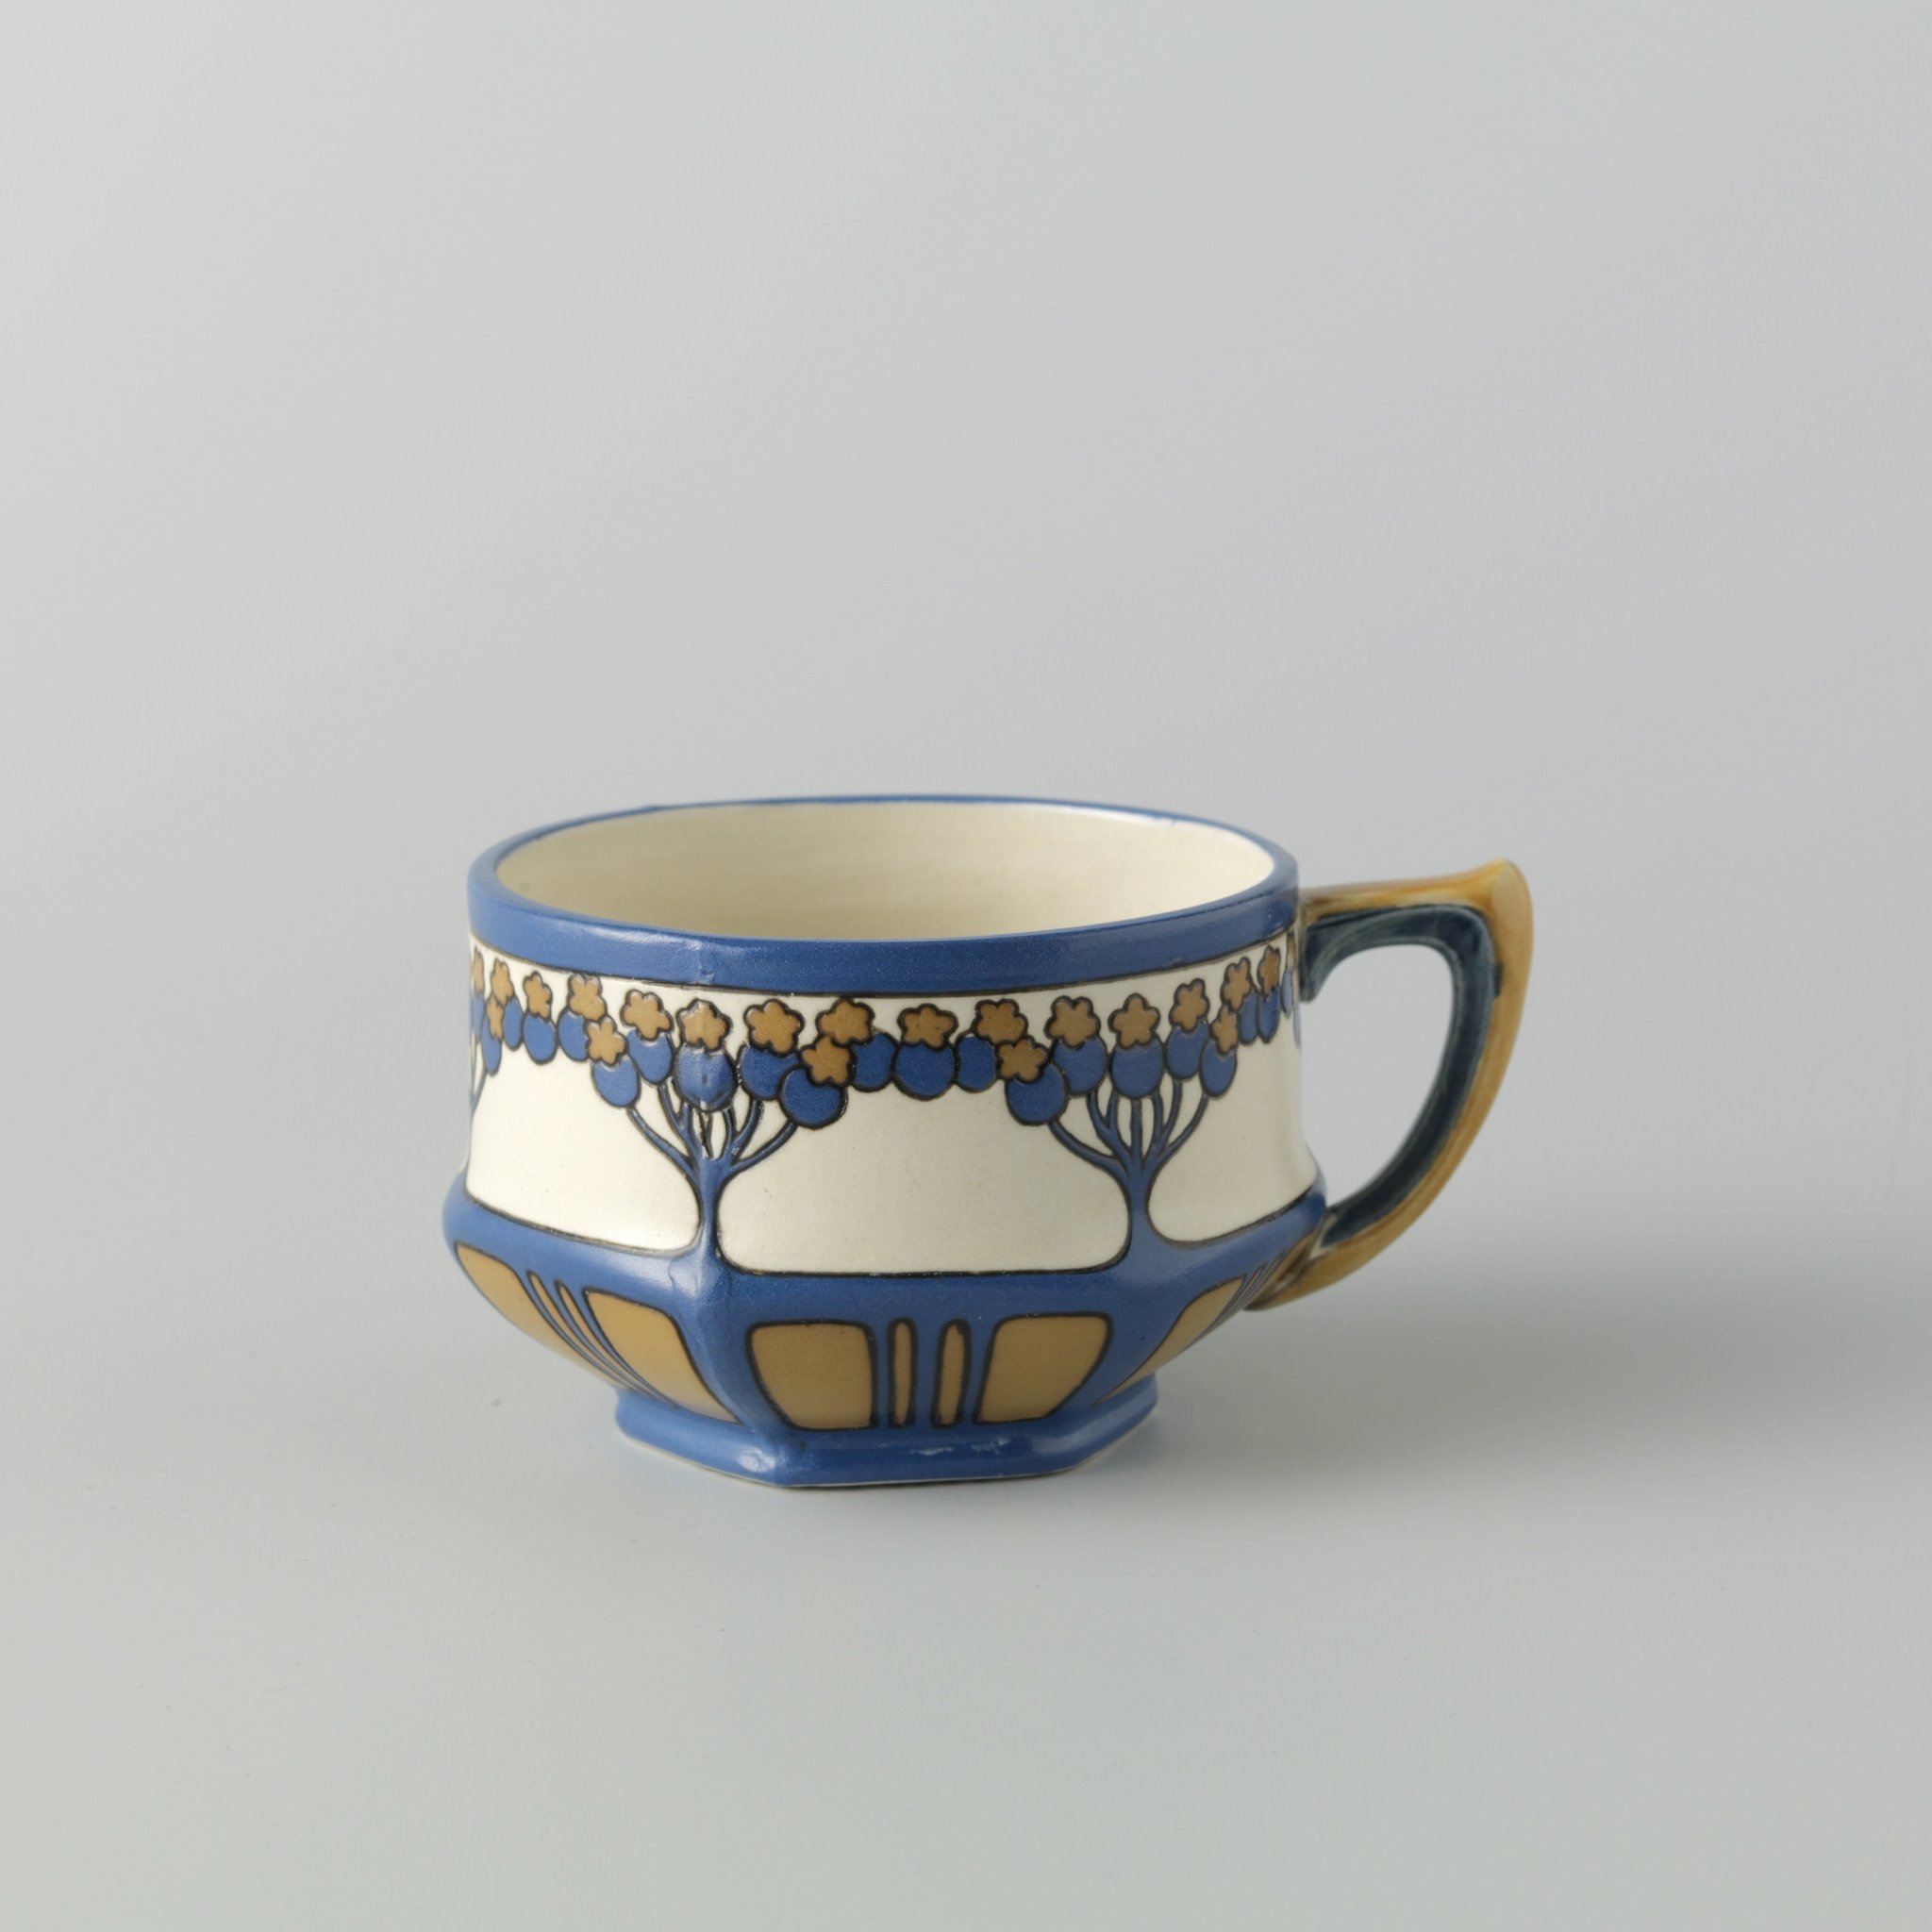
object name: cup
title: Kop, behorende bij een theeservies van chromolith steengoed, versierd in blauw en geelbruin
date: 1911-1912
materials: stoneware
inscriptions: mark: ‘ingedrukt toren // METTLACH waaronder VB in naamplaat, Ges.Gesch., Reg. U.S.Pat.OFF // Made in Germany, 2962, 2, 12; 45 geschilderd.’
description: Kop, behorende bij een theeservies van chromolith steengoed. Versiering in blauw en geelbruin. Onderste helft kop is zeshoekig.